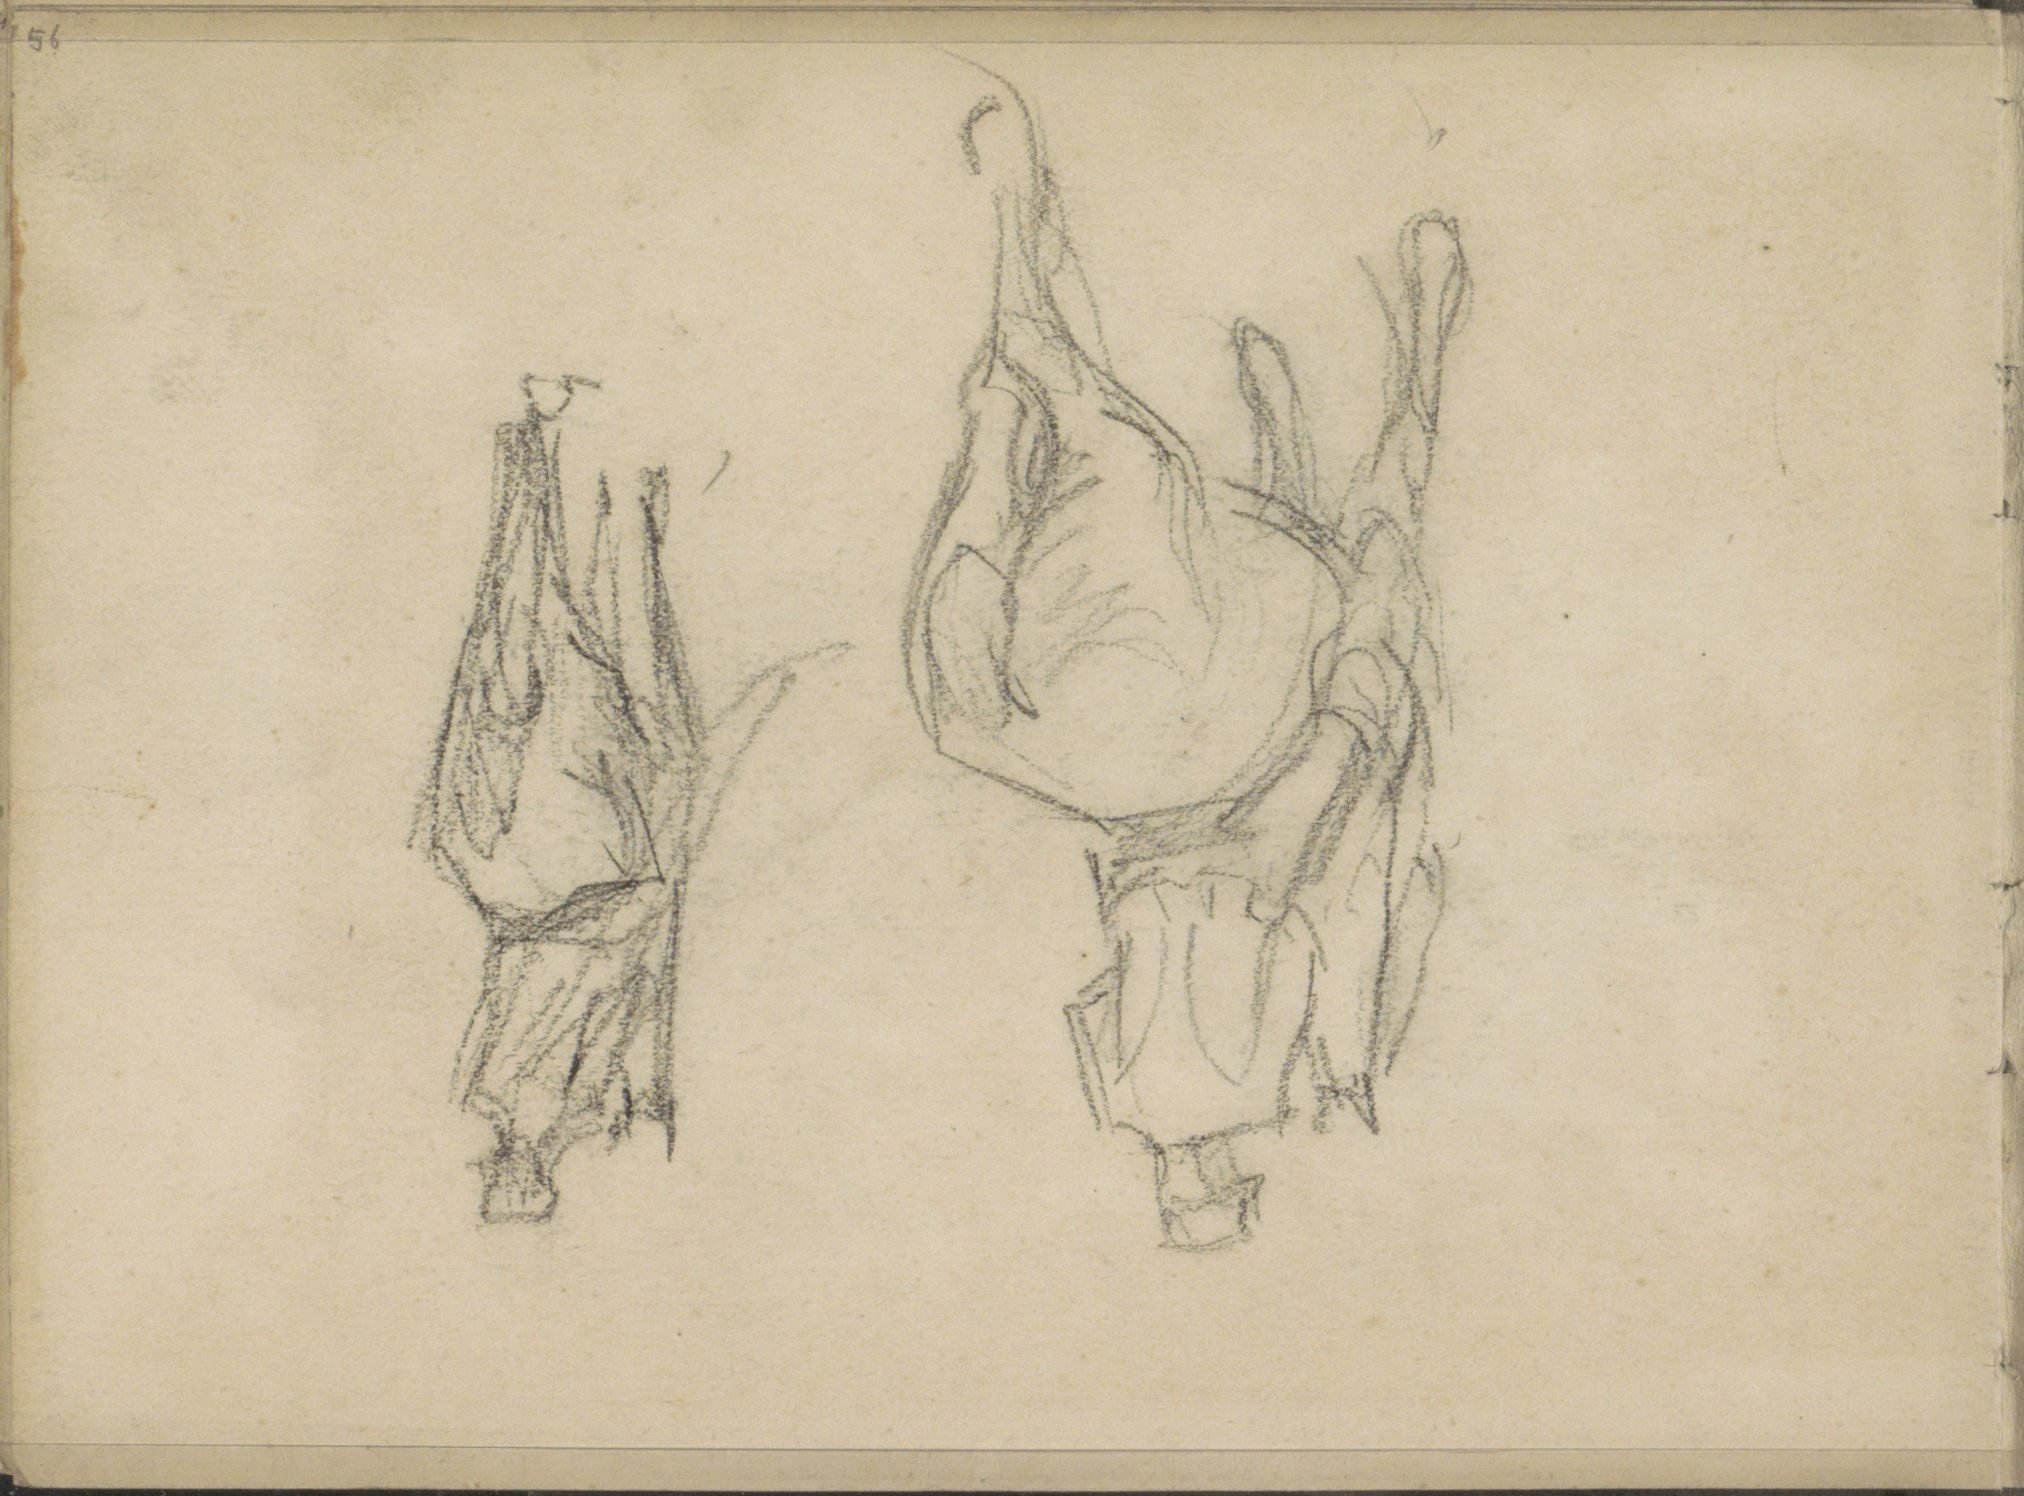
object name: sketchbook leaf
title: Twee ruiters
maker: marius bauer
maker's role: draughtsman, print maker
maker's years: 1867-1932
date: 1879-1884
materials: chalk, paper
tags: riding a horse, ass, or mule; rider, horseman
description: De twee ruiters zijn op de rug gezien getekend. Pagina 56 uit een schetsboek met 28 bladen.